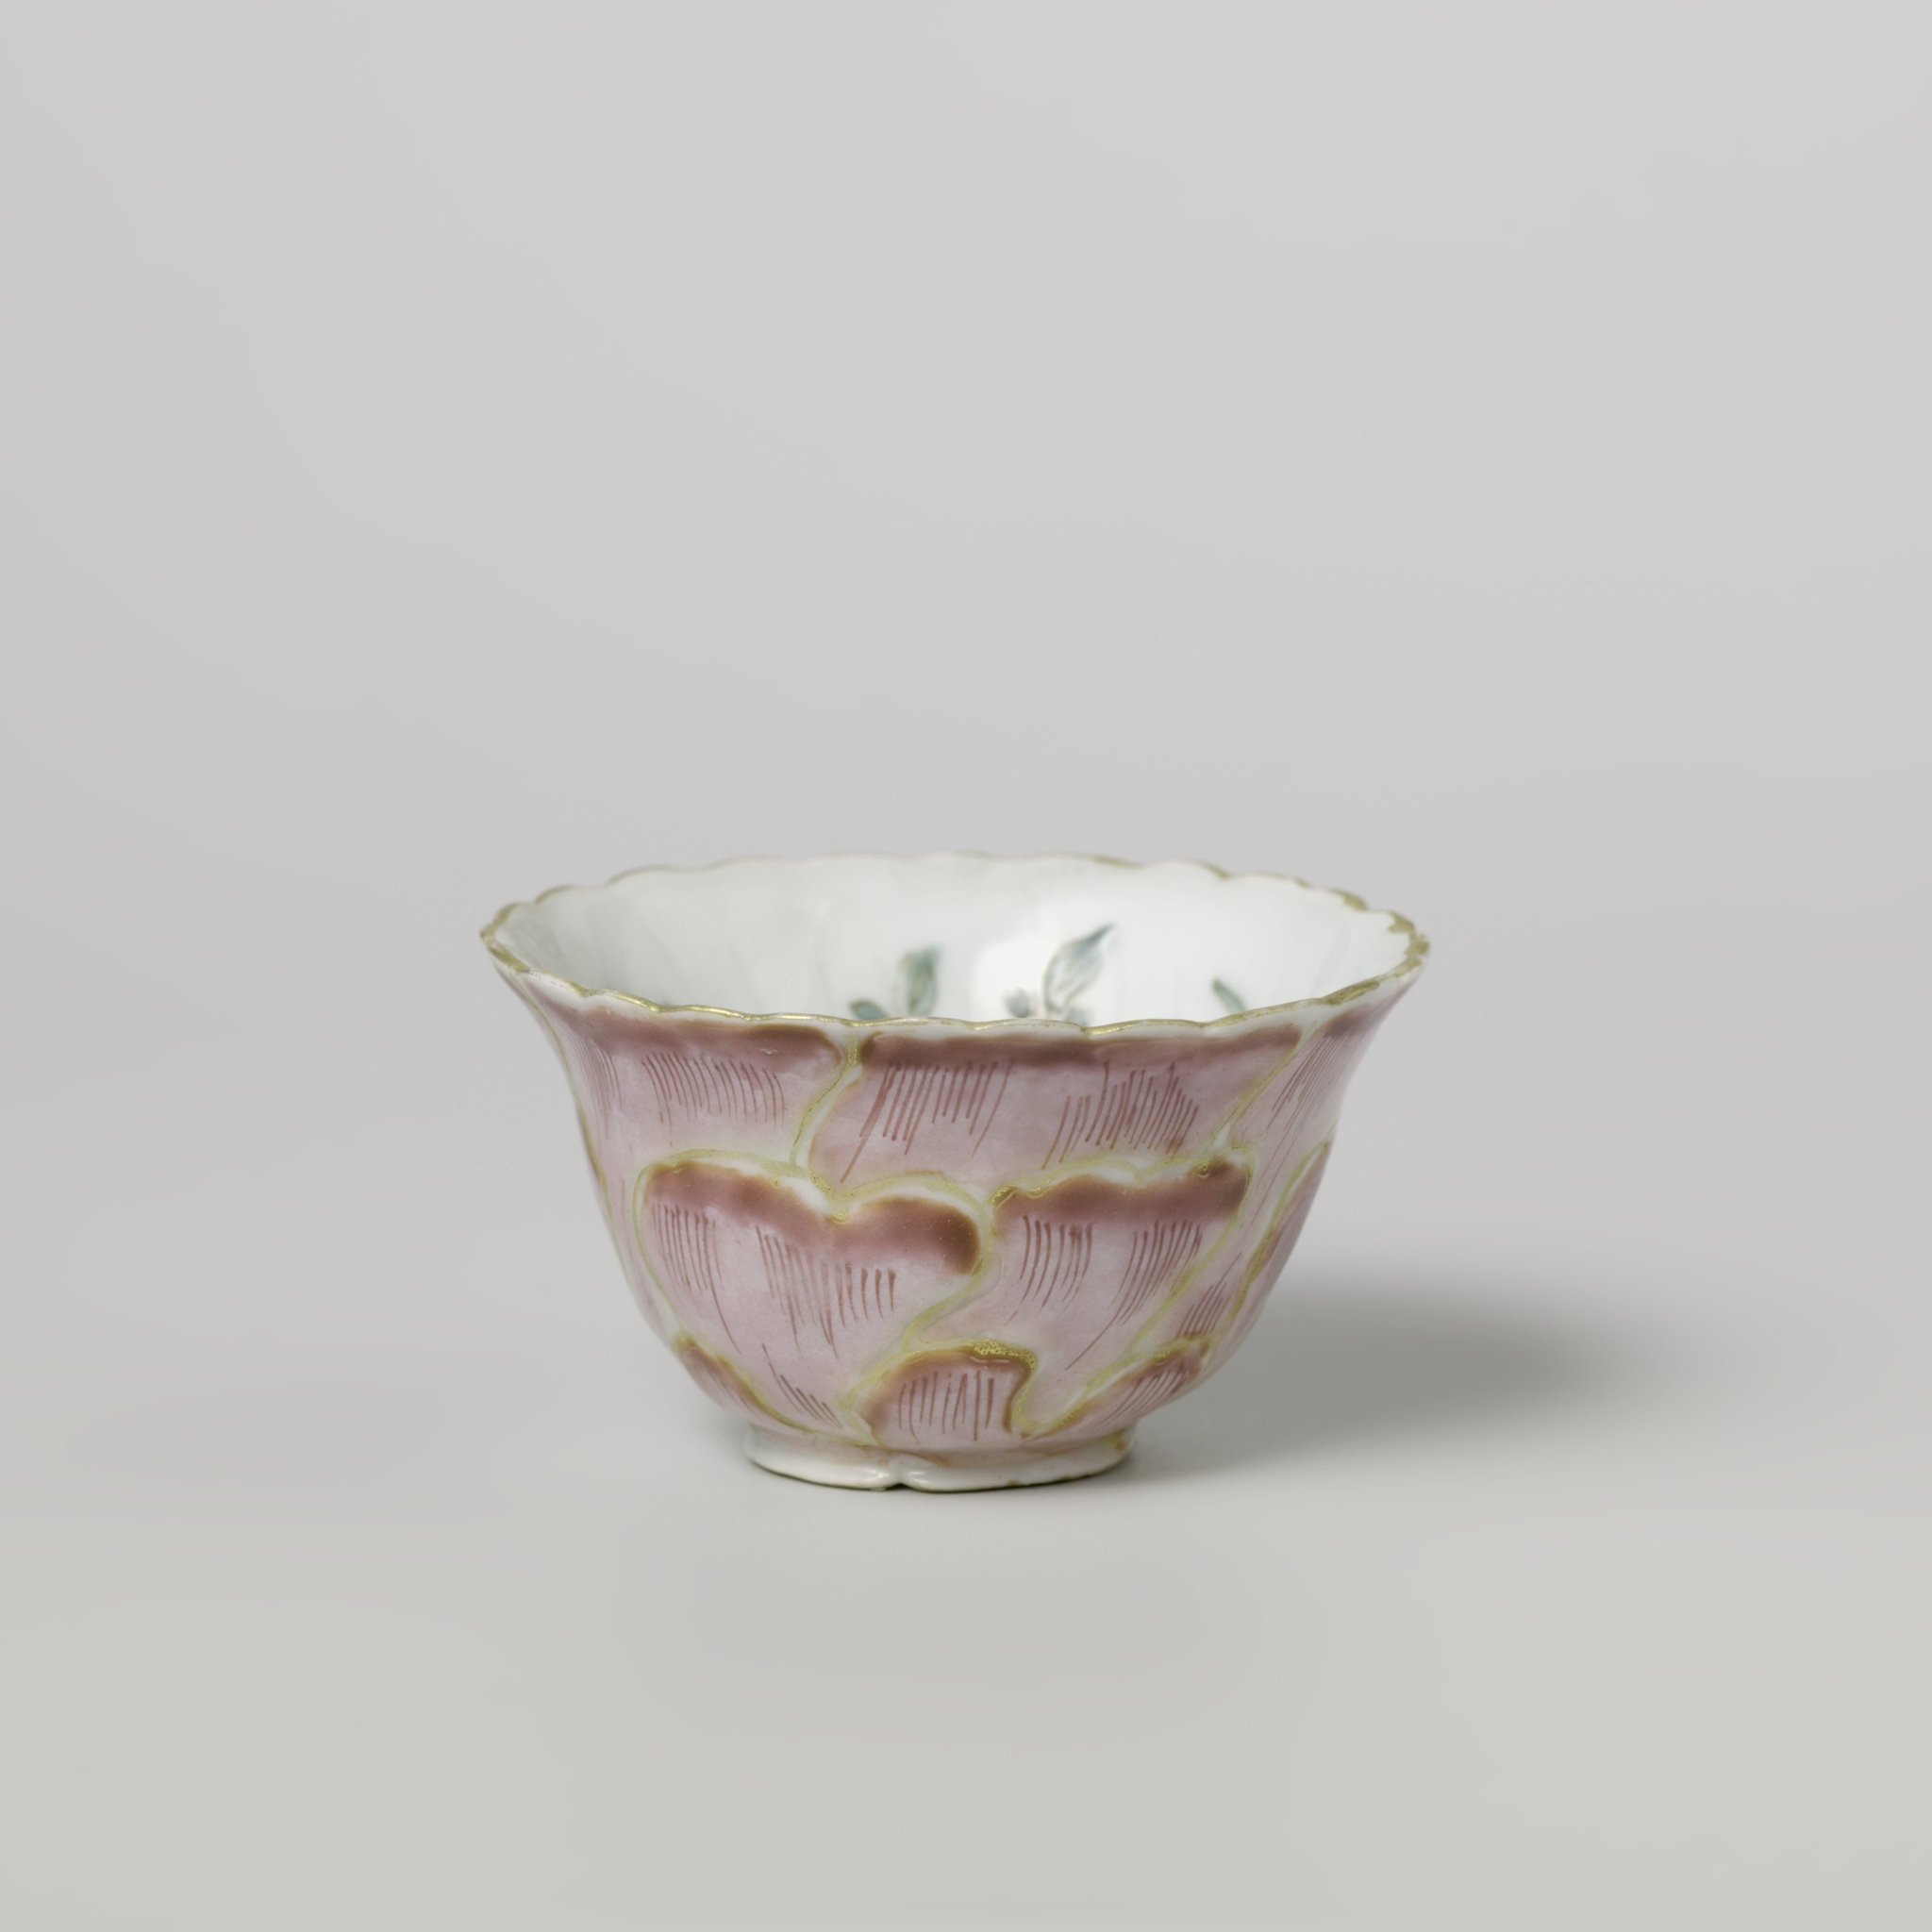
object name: cup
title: Bell-shaped cup modelled in the shape of a flower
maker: Anonymous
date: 1740-1760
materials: glaze, gold, paint, porcelain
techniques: firing, gilding, turning, vitrification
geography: china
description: AK-NM-6406 en 6407 Zes koppen en schotels • Famille rose porselein • Onderdeel van Royers porseleincollectie • Mogelijk afkomstig van Susanna Louise Huygens De koppen en schotels zijn gevormd als zich openende bloemblaadjes en de stengels en blaadjes vormen de voet van de schotels. Het navolgen van elementen uit de natuur kwam bij het vormen van keramiek in China vaker voor. Royer had daar zelf voorbeelden van bij zijn Yixing theepotten (AK-NM-6568 en -6580 bijvoorbeeld) en bij zijn blanc de Chine porselein (de bakjes AK-NM-6534). Dit soort theegoed dat in vrij veel andere collecties ook te vinden is en waar dus blijkbaar enthousiasme voor bestond onder de Europese kopers, volgt hetzelfde principe, maar is verder gestandaardiseerd en – mede door de beschildering – een tikje kitschiger [Wirgin 1998, nr. 93]. Opvallend is dat juist ook in vorstelijke collecties deze koppen en schotels te vinden zijn: in Londen, Dresden, Kopenhagen [Ayers 2016, vol. I, nrs. 761-766, Reichel 1993, nr. 28, Grandjean 1965, nr. 12, pl. 28]. Informatie over die vorstelijke collecties helpt bij het dateren. In Dresden werden de kopjes tussen 1727 en 1729 geïnventariseerd en in Kopenhagen hebben ze een monogram van koning Christiaan VI die van 1730 tot 1746 regeerde. Ze zijn dus vroeger dan je zou denken. Royer kon ze waarschijnlijk in 1786 overnemen uit de nalatenschap van zijn oudtante Susanna Louise Huygens (1714-1785). In de beschrijving van haar gekleurde porselein vinden we ‘ses paar thee goed, van buiten rood, schulpwerk, en van binnen marseille met bouquetten, de schoteltjes met geboutzeer rankwerk.’ Deze koppen en schotels horen dus bij de porseleinverzameling. Dit in tegenstelling tot de vele koffie- en theeserviezen en losse series theegoed die volgens de boedelbeschrijving opgemaakt na het overlijden van de weduwe Royer, ergens een plek in huis hadden. Bronnen: Bredo L. Grandjean, Dansk Ostindisk porcelaen importen fra Kanton ca. 1700-1822, Kopenhagen, 1965. Friedrich Reichel, Die Porzellansammlung Augusts des Starken: Porzellankunst aus China, die rosa Familie, München, 1993. Jan Wirgin, Fran Kina till Europa. Kinesiska konstföremal fran de ostindiska kompaniernas tid, Stockholm, 1998. John Ayers, Chinese and Japanese works of art in the collection of Her Majesty The Queen, Londen, 2016.